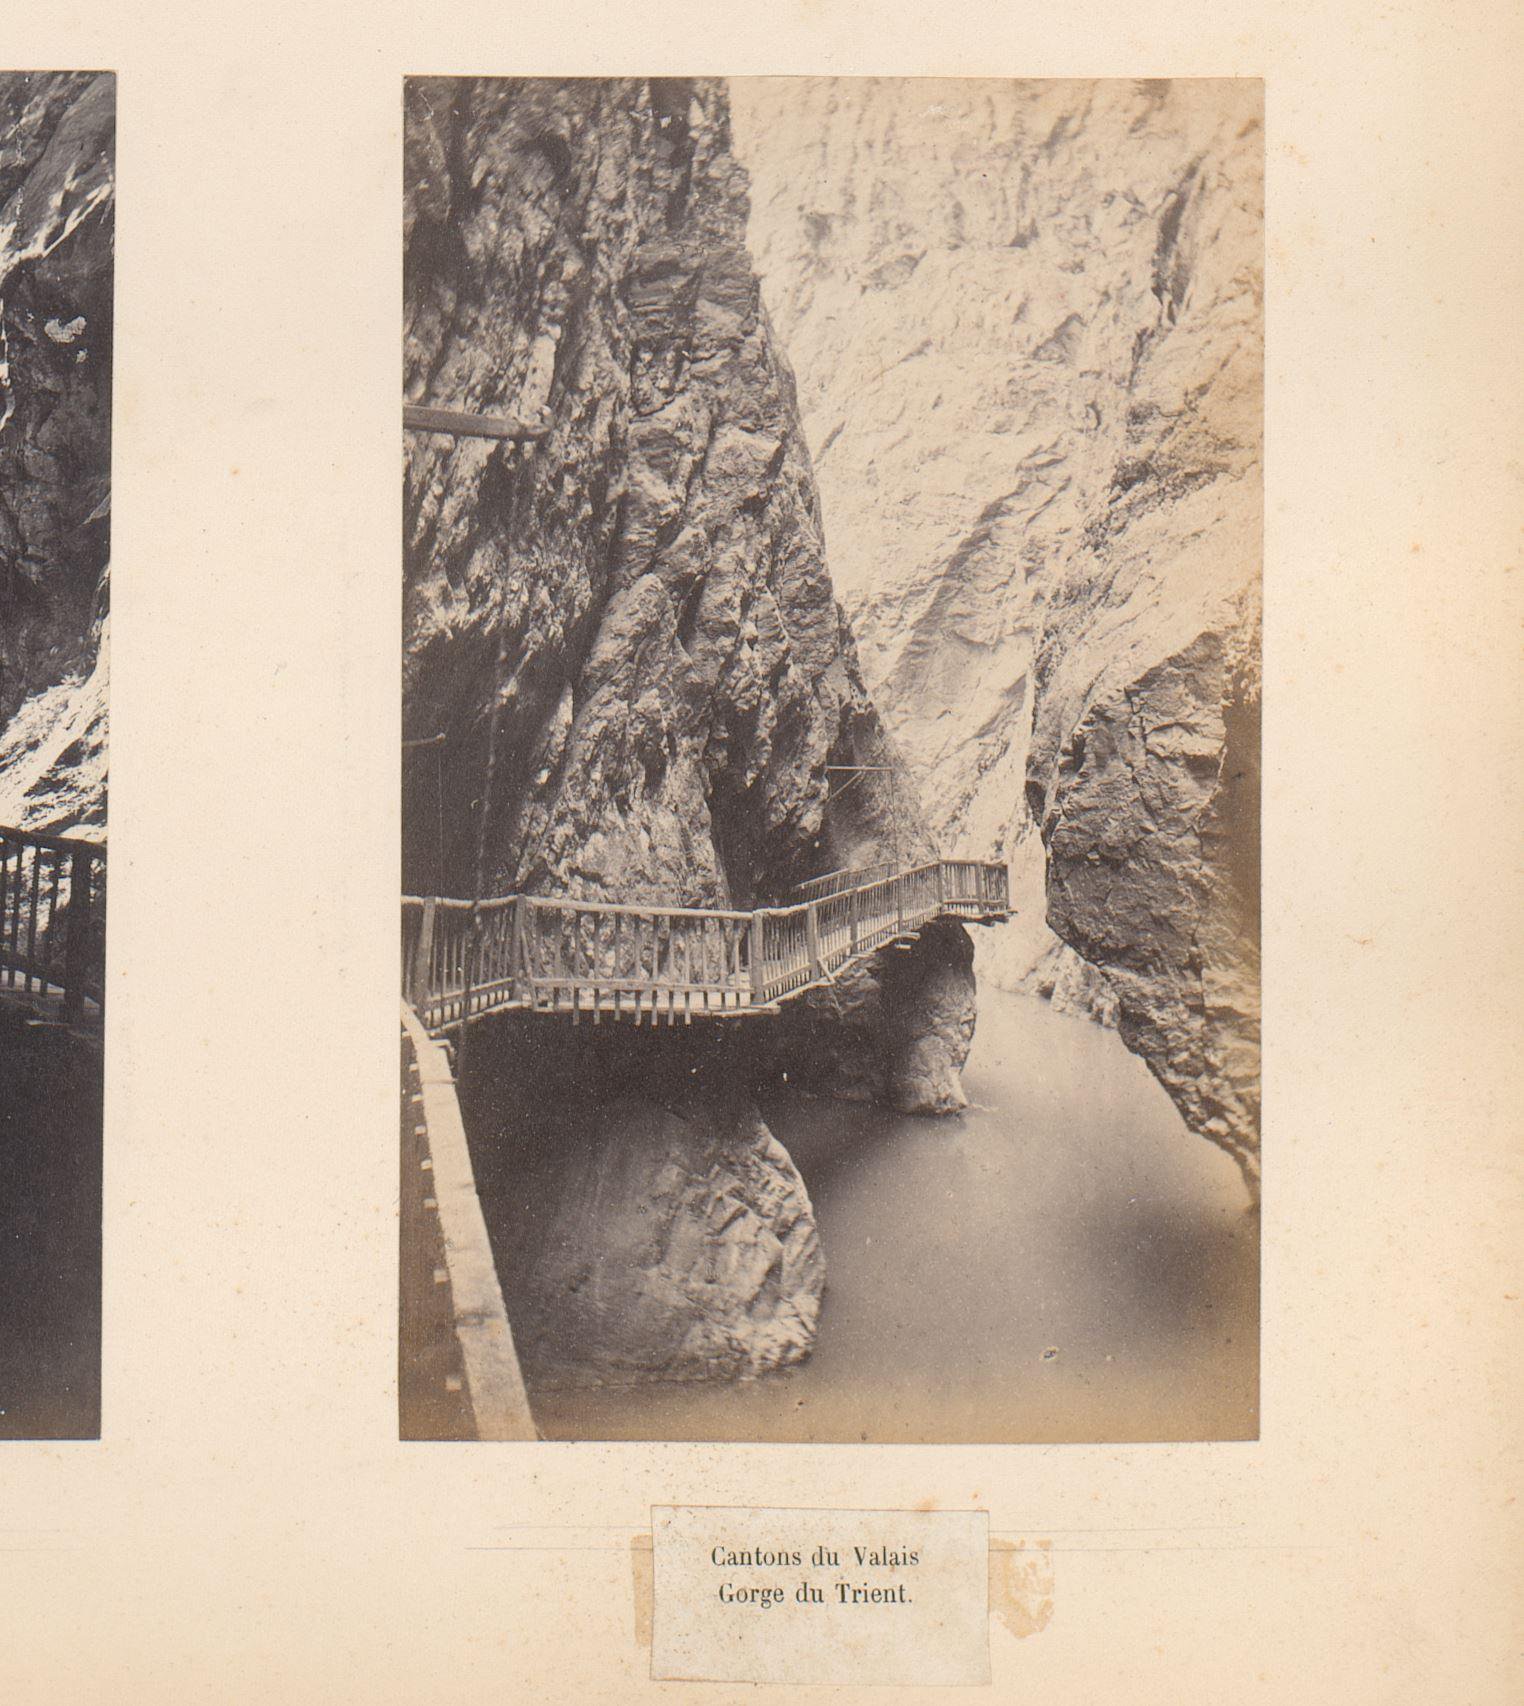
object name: photograph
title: Kloof van Trient in het kanton Valais, Zwitserland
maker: Anonymous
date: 1860-1890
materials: paper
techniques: albumen print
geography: wallis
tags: ravine, chasm, abyss, canyon, brook, bridge